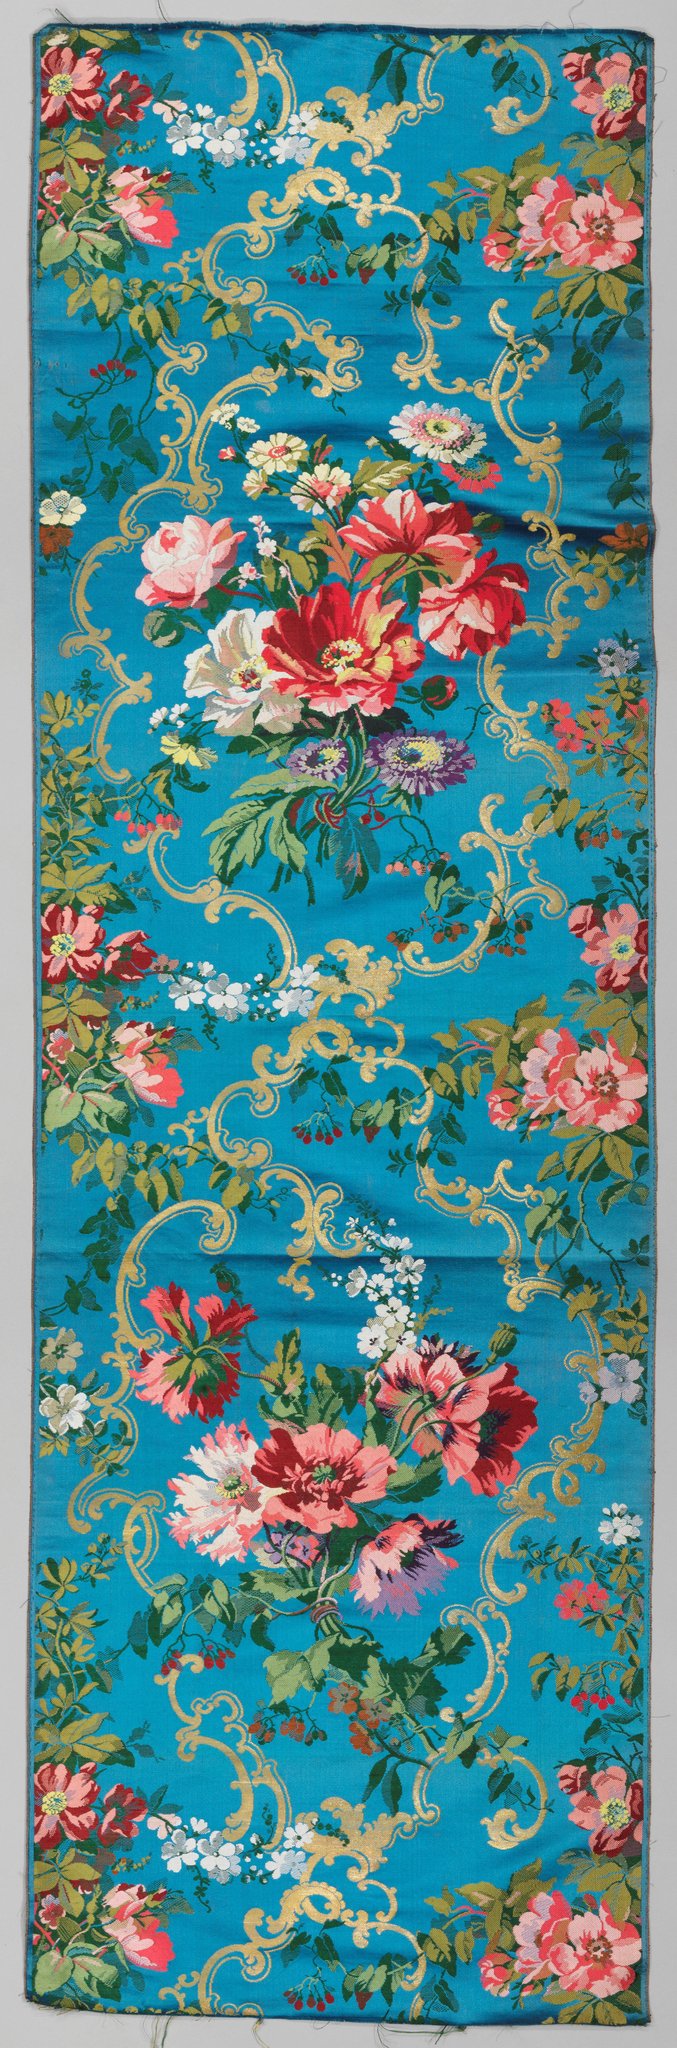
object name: silk textile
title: Zijdeweefsel met bloempatroon, onder meer met pioenrozen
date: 1840-1850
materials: silk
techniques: brocade, lampas, weave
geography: lyon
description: Wall covering. Brocaded silk. France, Lyon, c. 1840 - 1850, by Tassinari & Chatel (?).